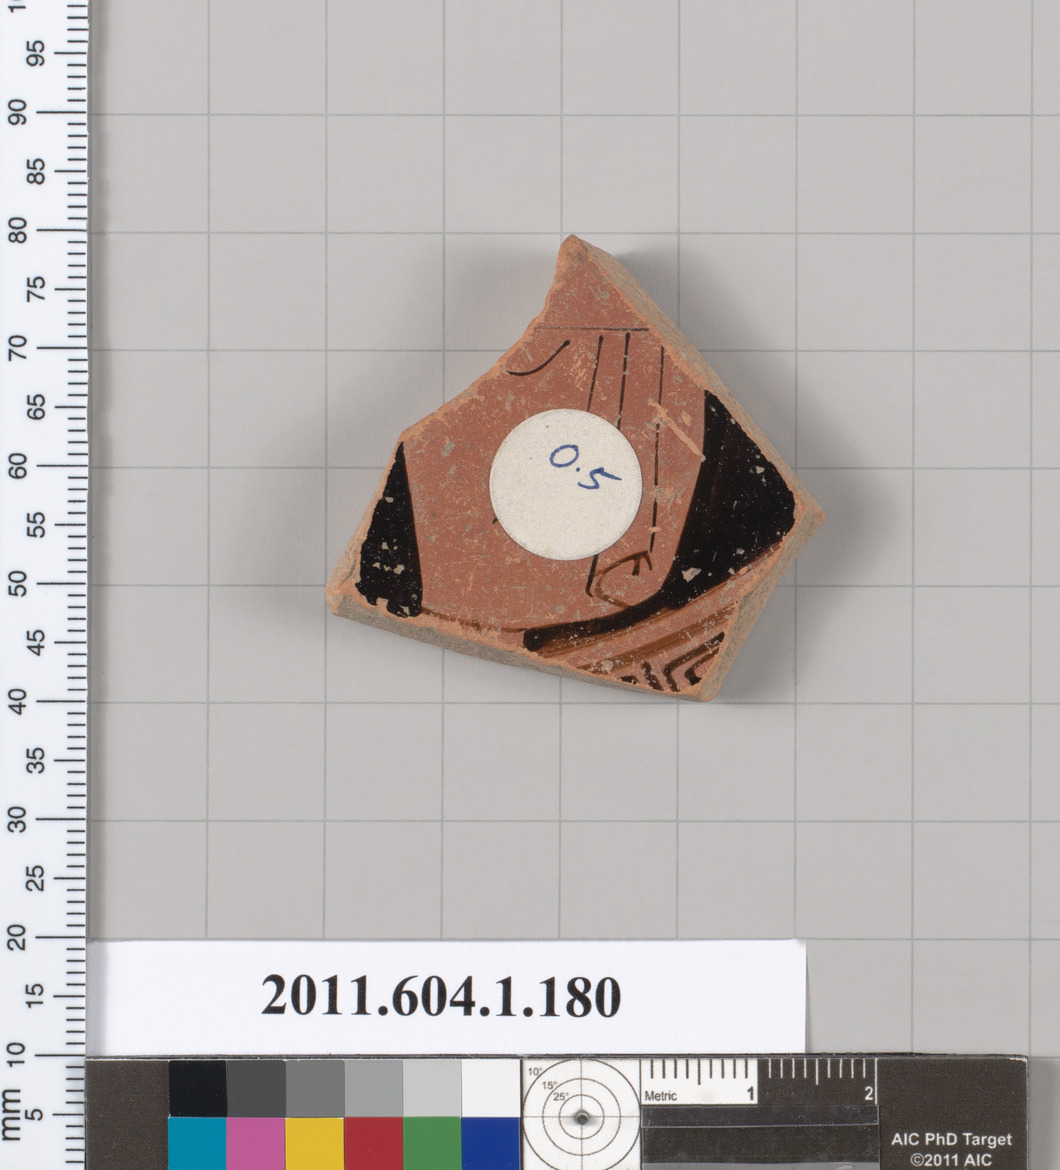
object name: kylix fragment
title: Terracotta fragment of a kylix (drinking cup)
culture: greek, attic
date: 475-451 BCE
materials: terracotta